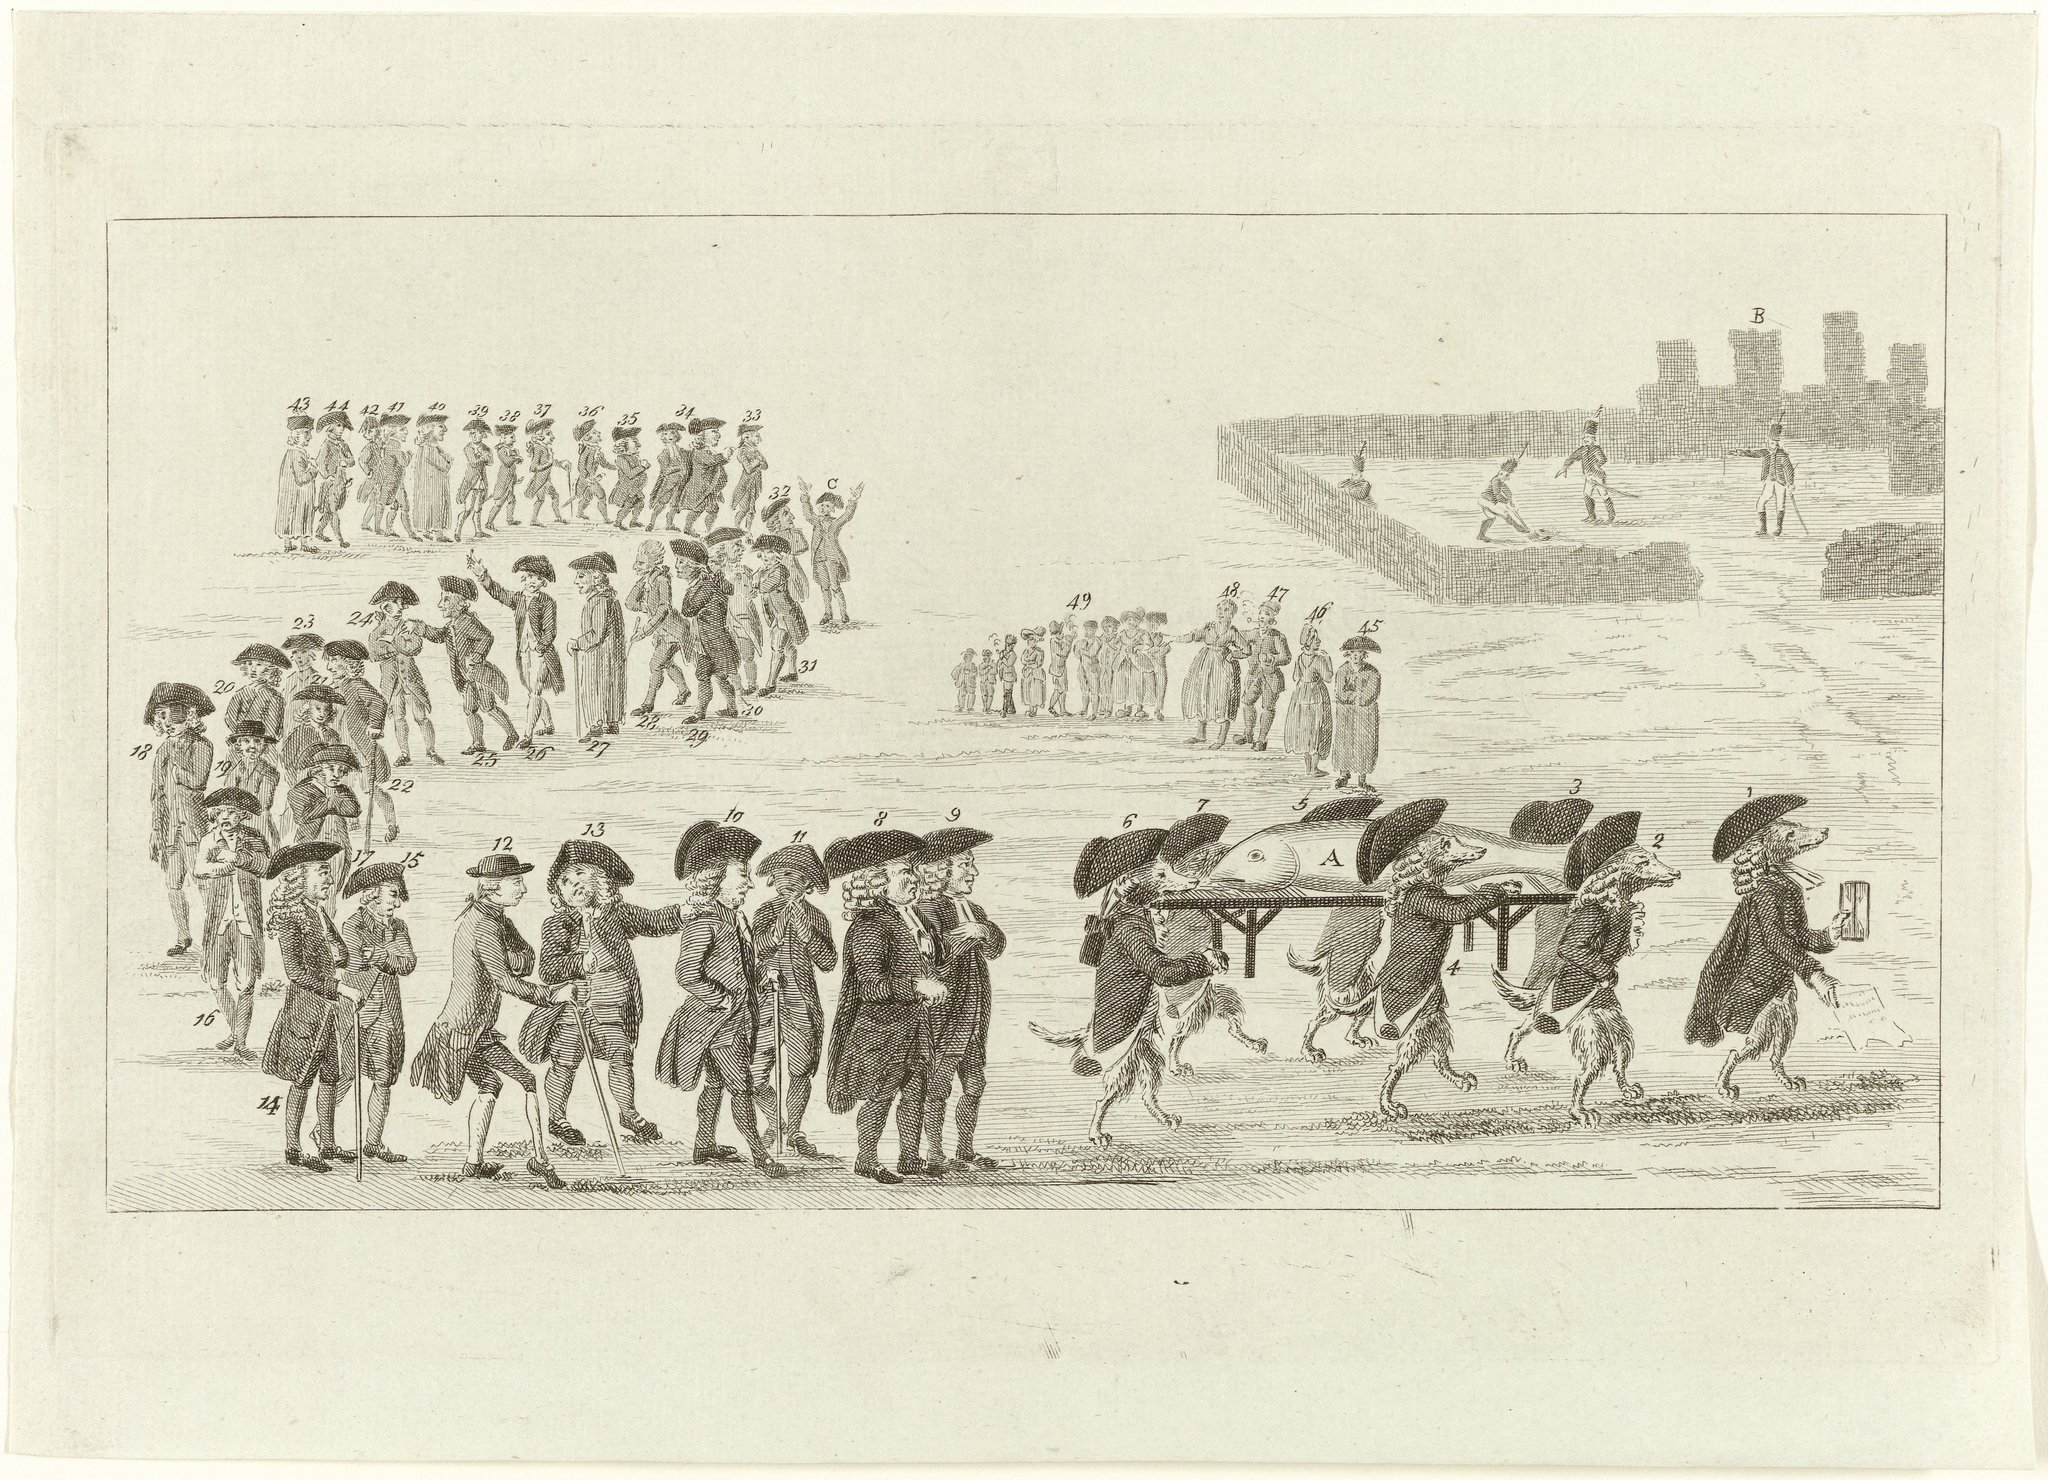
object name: print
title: Begrafenis van een dode zalm, 1787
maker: Anonymous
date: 1787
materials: paper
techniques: engraving, etching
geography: northern netherlands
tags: rijngraaf van salm frederik iii, animals acting as human beings, bony fishes: salmon, cortege, funeral procession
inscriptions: collector's mark: Lugt 2228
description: Spotprent op de Rijngraaf van Salm. Een begrafenisstoet waarin keeshonden een baar dragen waarop een overleden zalm ligt. Achter de baar loopt een stoet van patriotten aangeduid met nummers. Op de achtergrond rechts een kerkhof waar Pruisische soldaten een graf graven voor de vis. Naar aanleiding van het verlaten van Utrecht door de Rijngraaf en de patriotten bij de nadering van de Pruisische troepen in september 1787. Bij de prent behoren een verklaring en een lees-cedul.